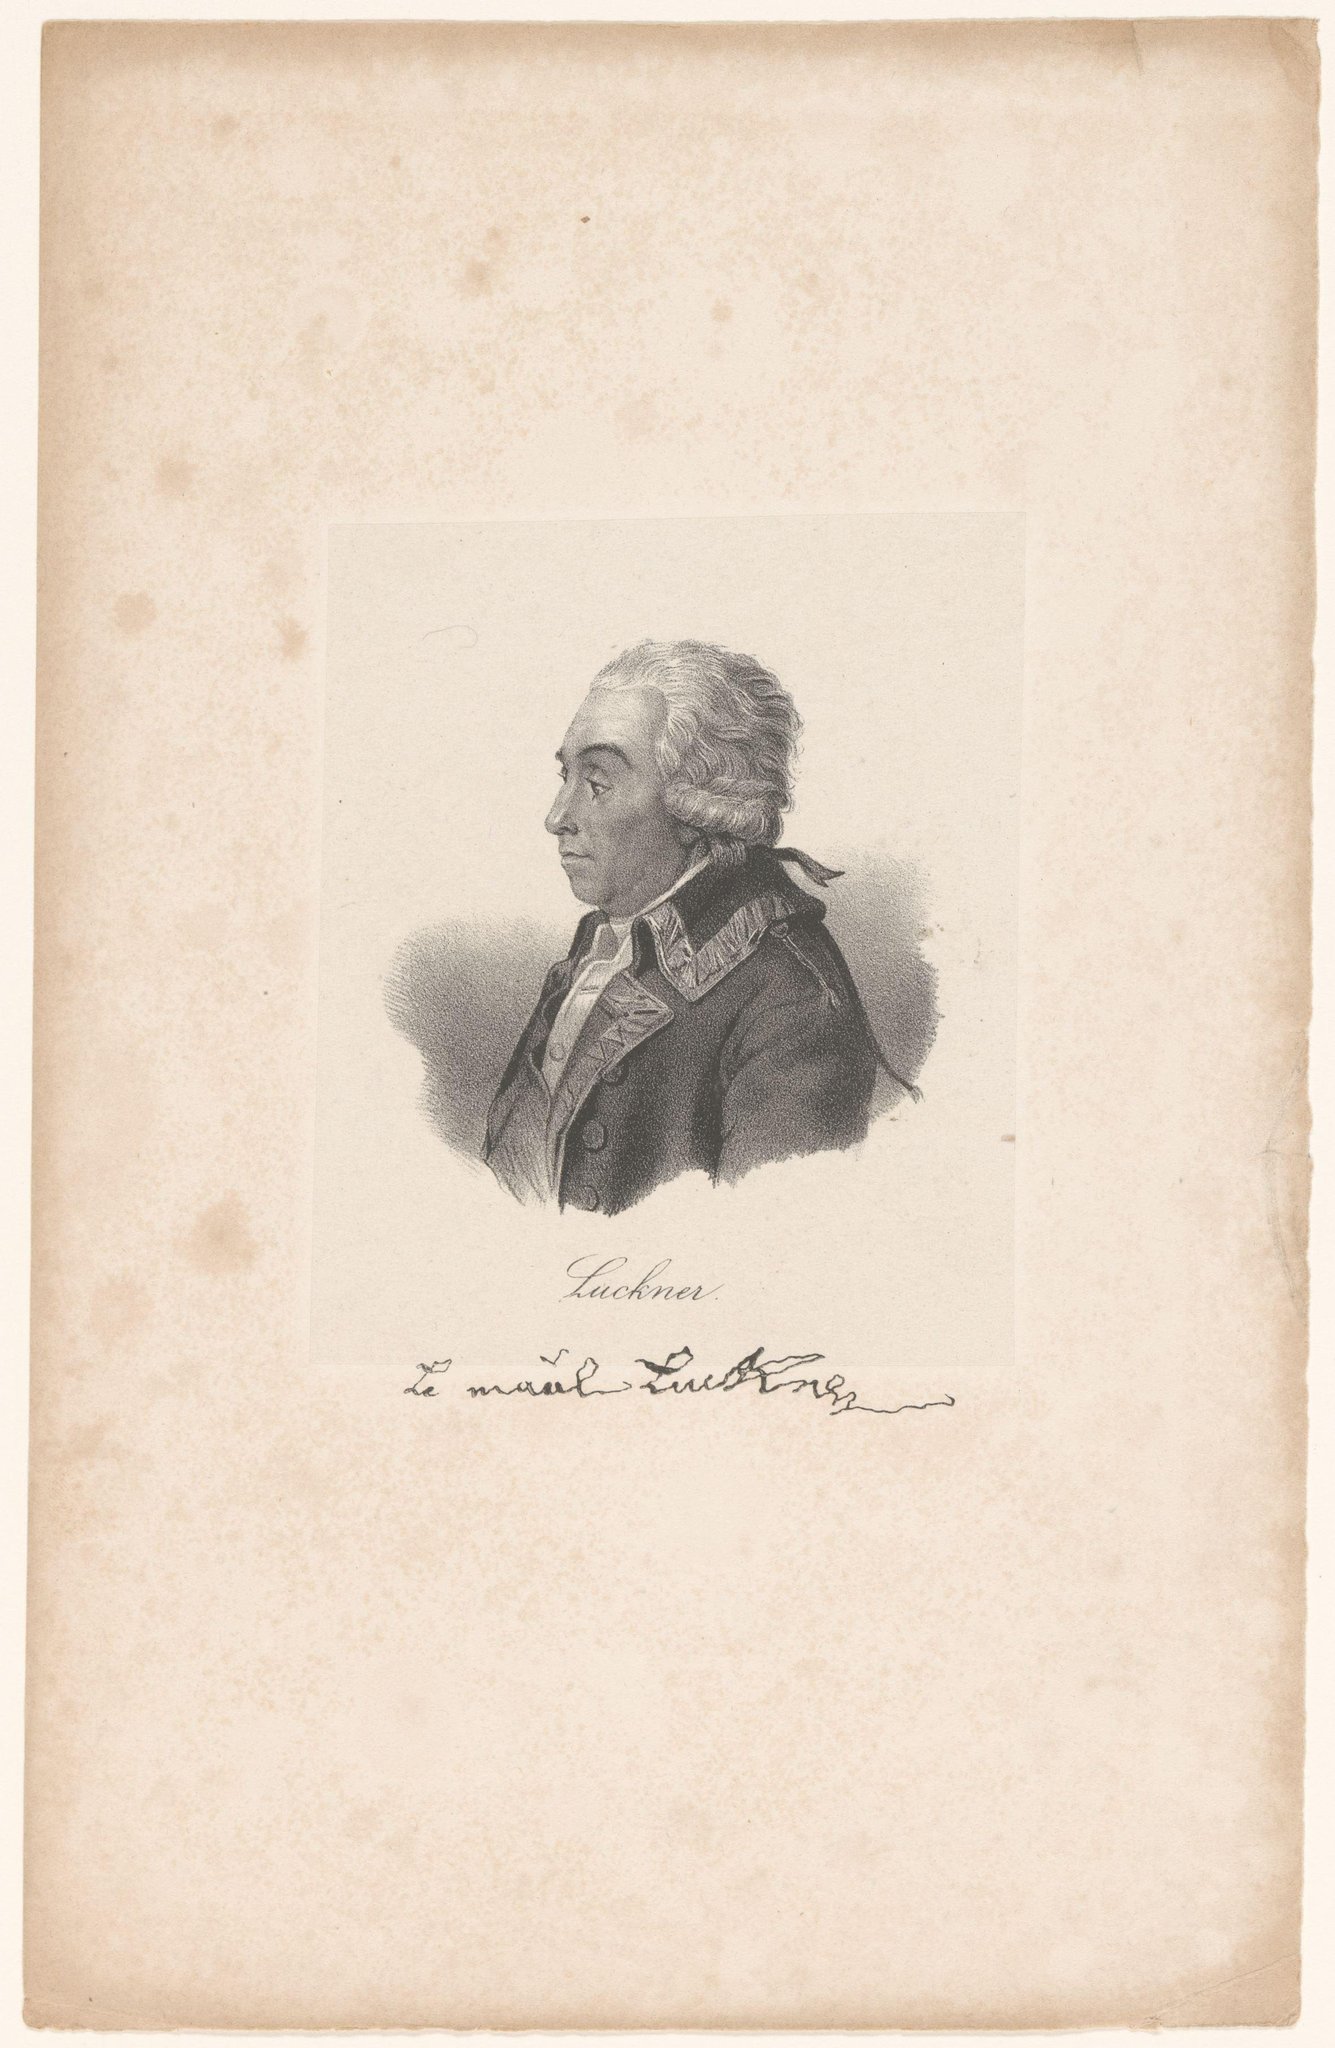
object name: print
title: Luckner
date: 1818-1842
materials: paper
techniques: lithograph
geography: paris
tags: germany, paris, historical persons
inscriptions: collector's mark: Lugt 2228a